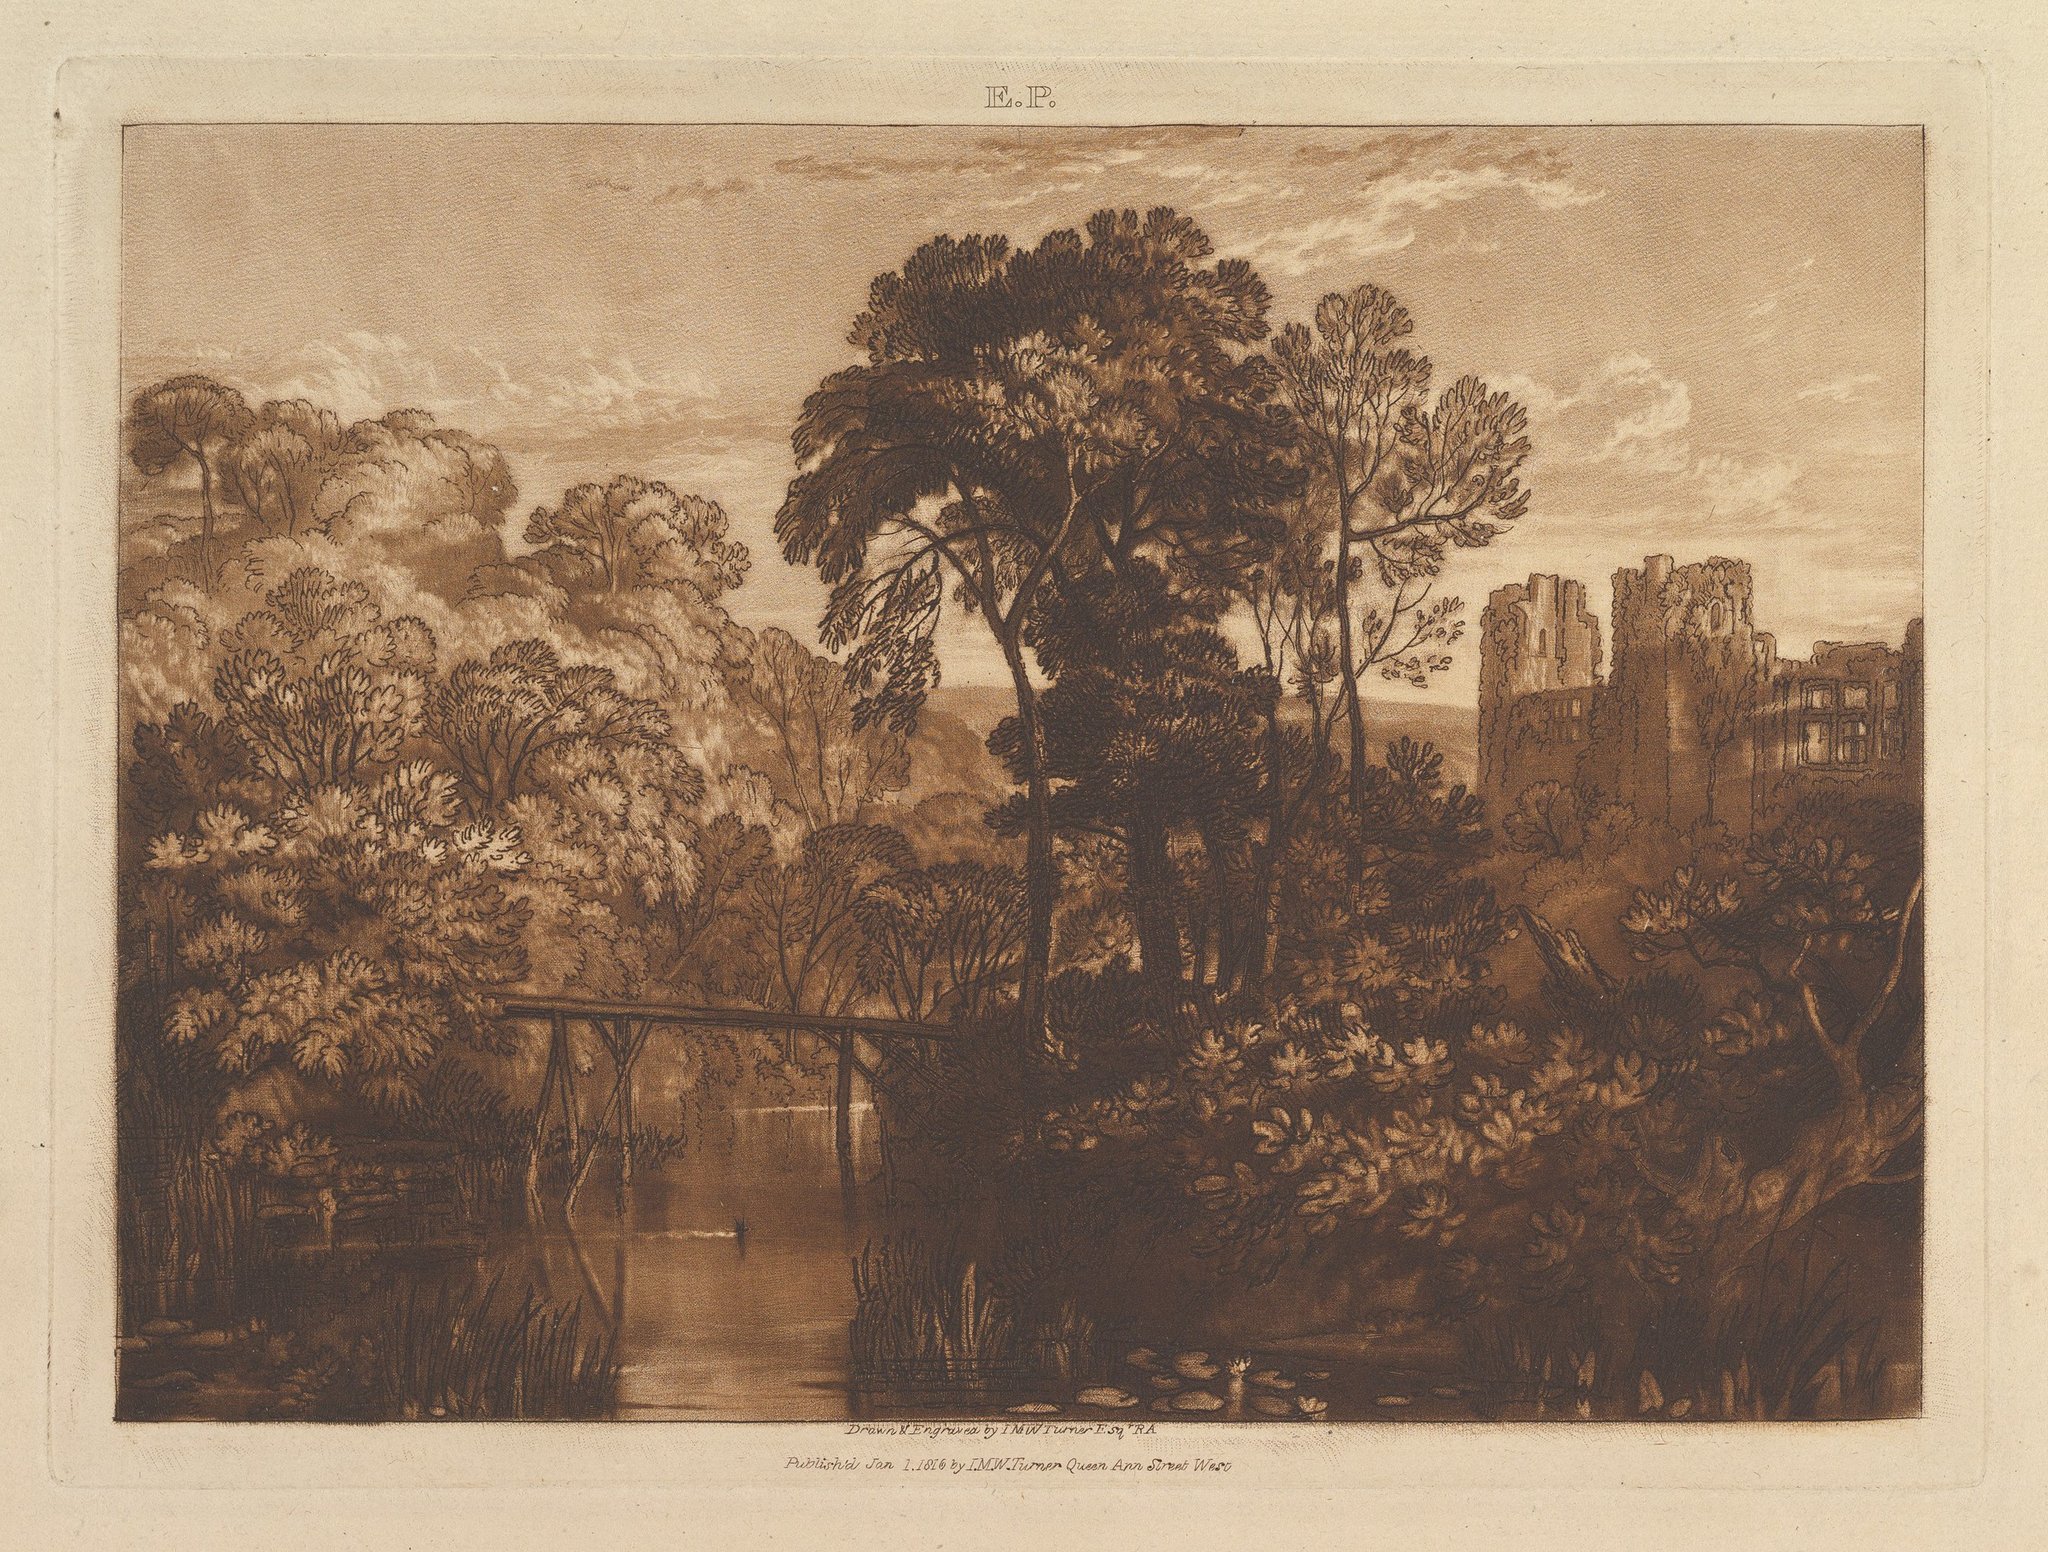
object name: print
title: Berry Pomeroy Castle, part XII, plate 58 from "Liber Studiorum"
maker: joseph mallord william turner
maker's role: artist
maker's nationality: british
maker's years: 1775-1851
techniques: etching, mezzotint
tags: castles,trees